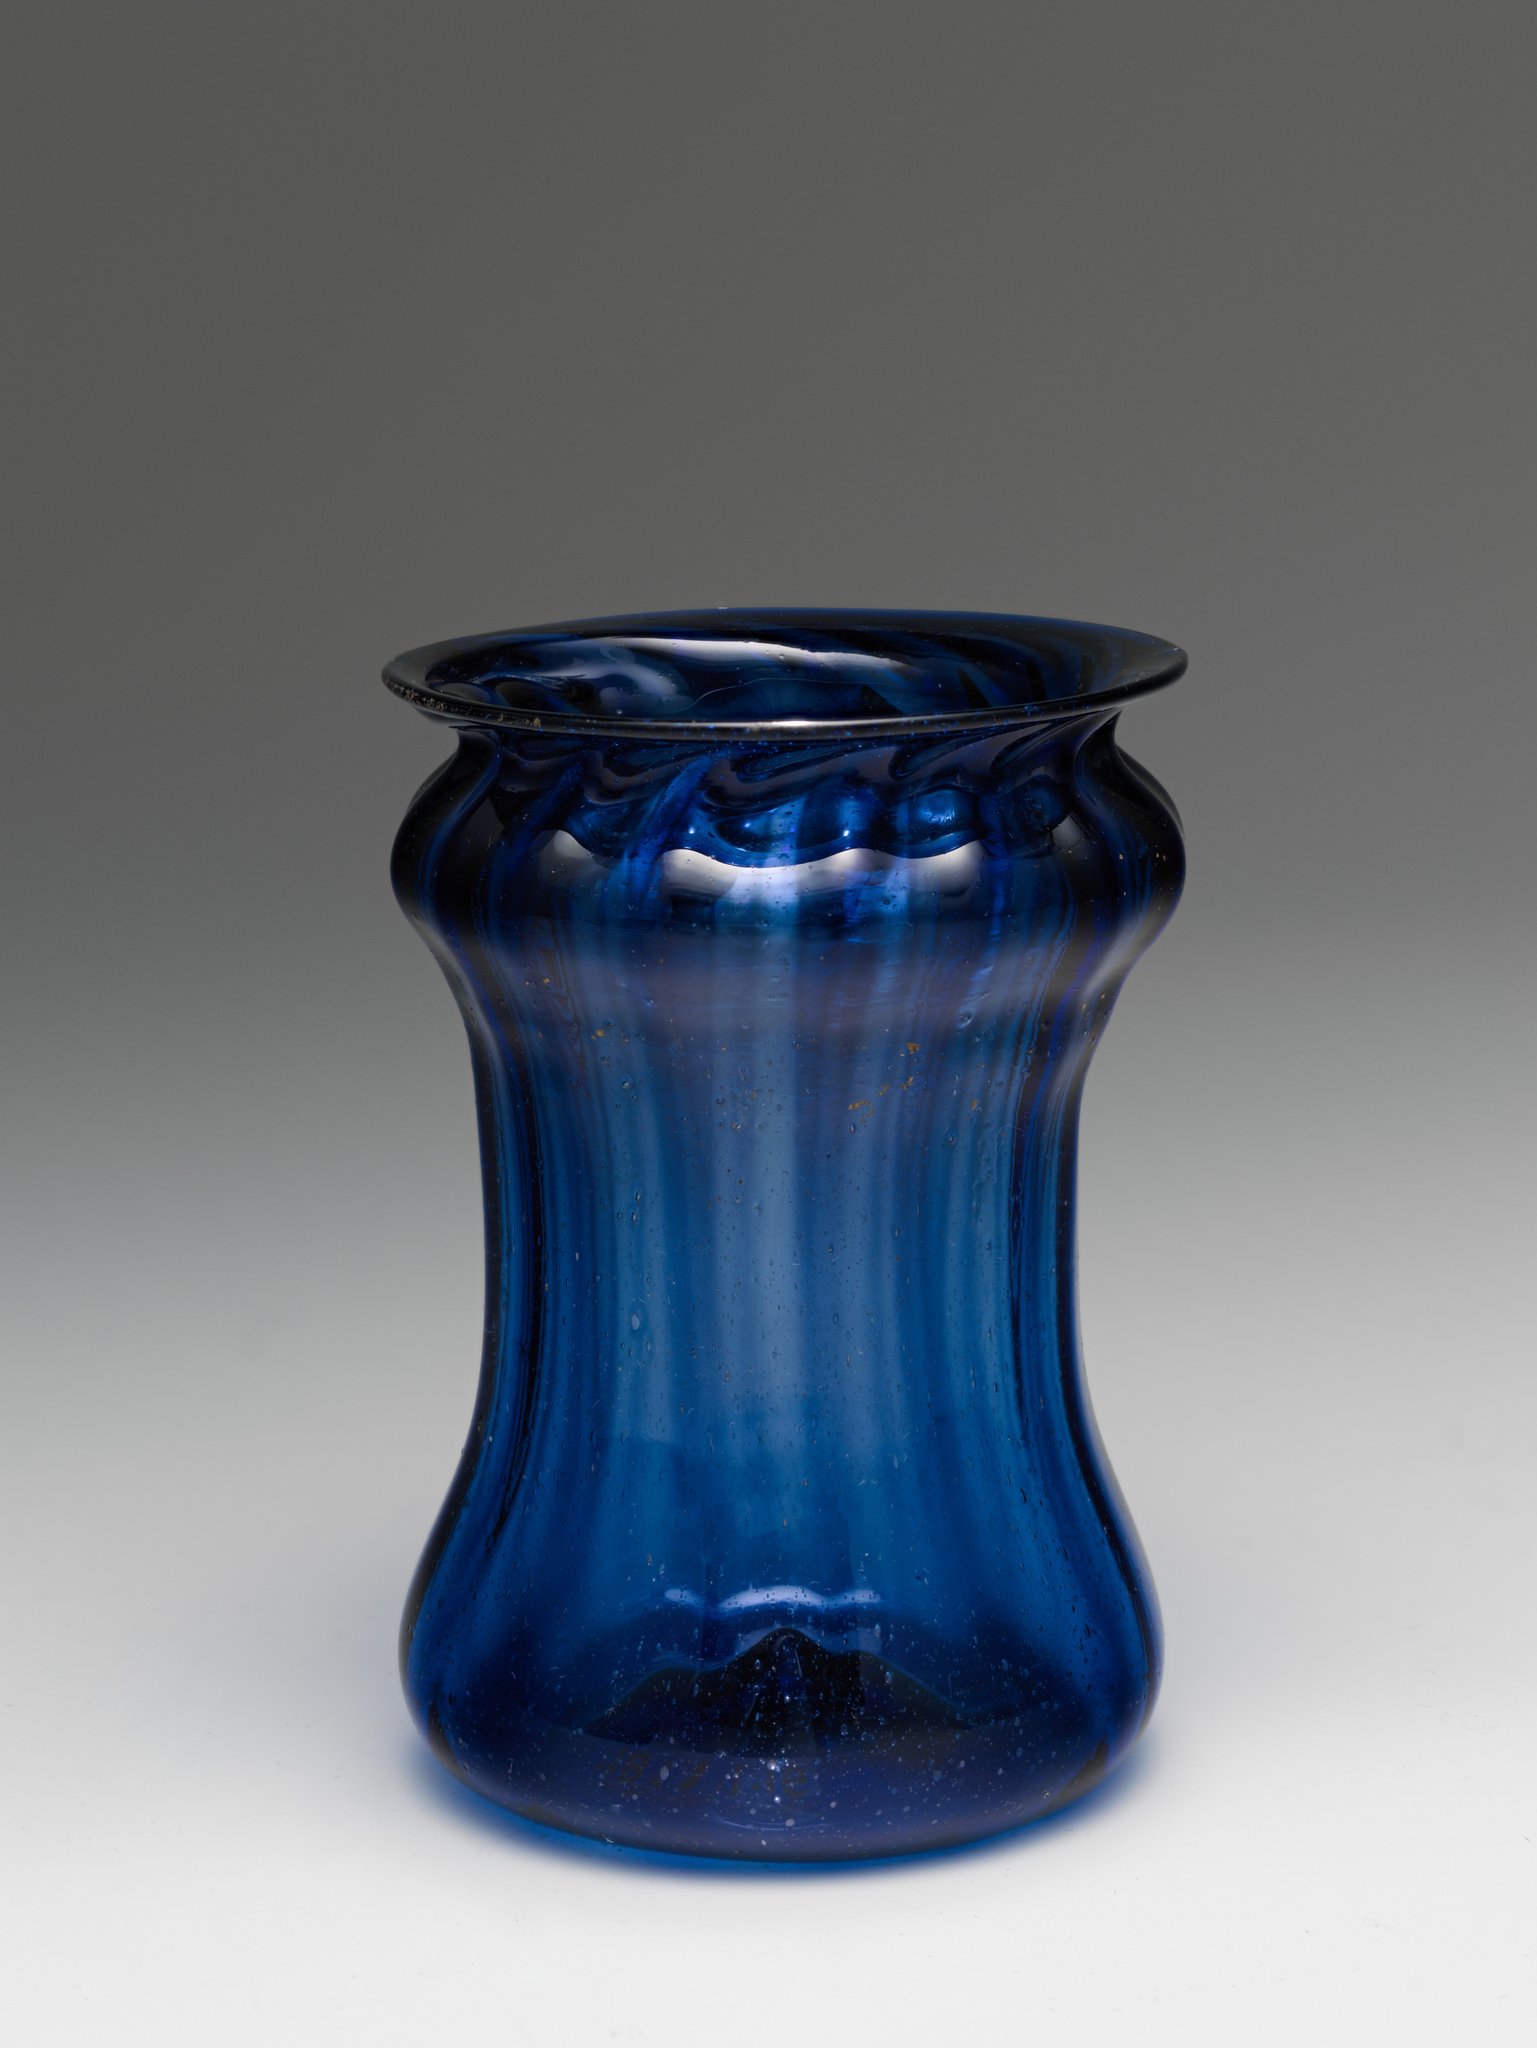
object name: jar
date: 1701-1800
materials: glass